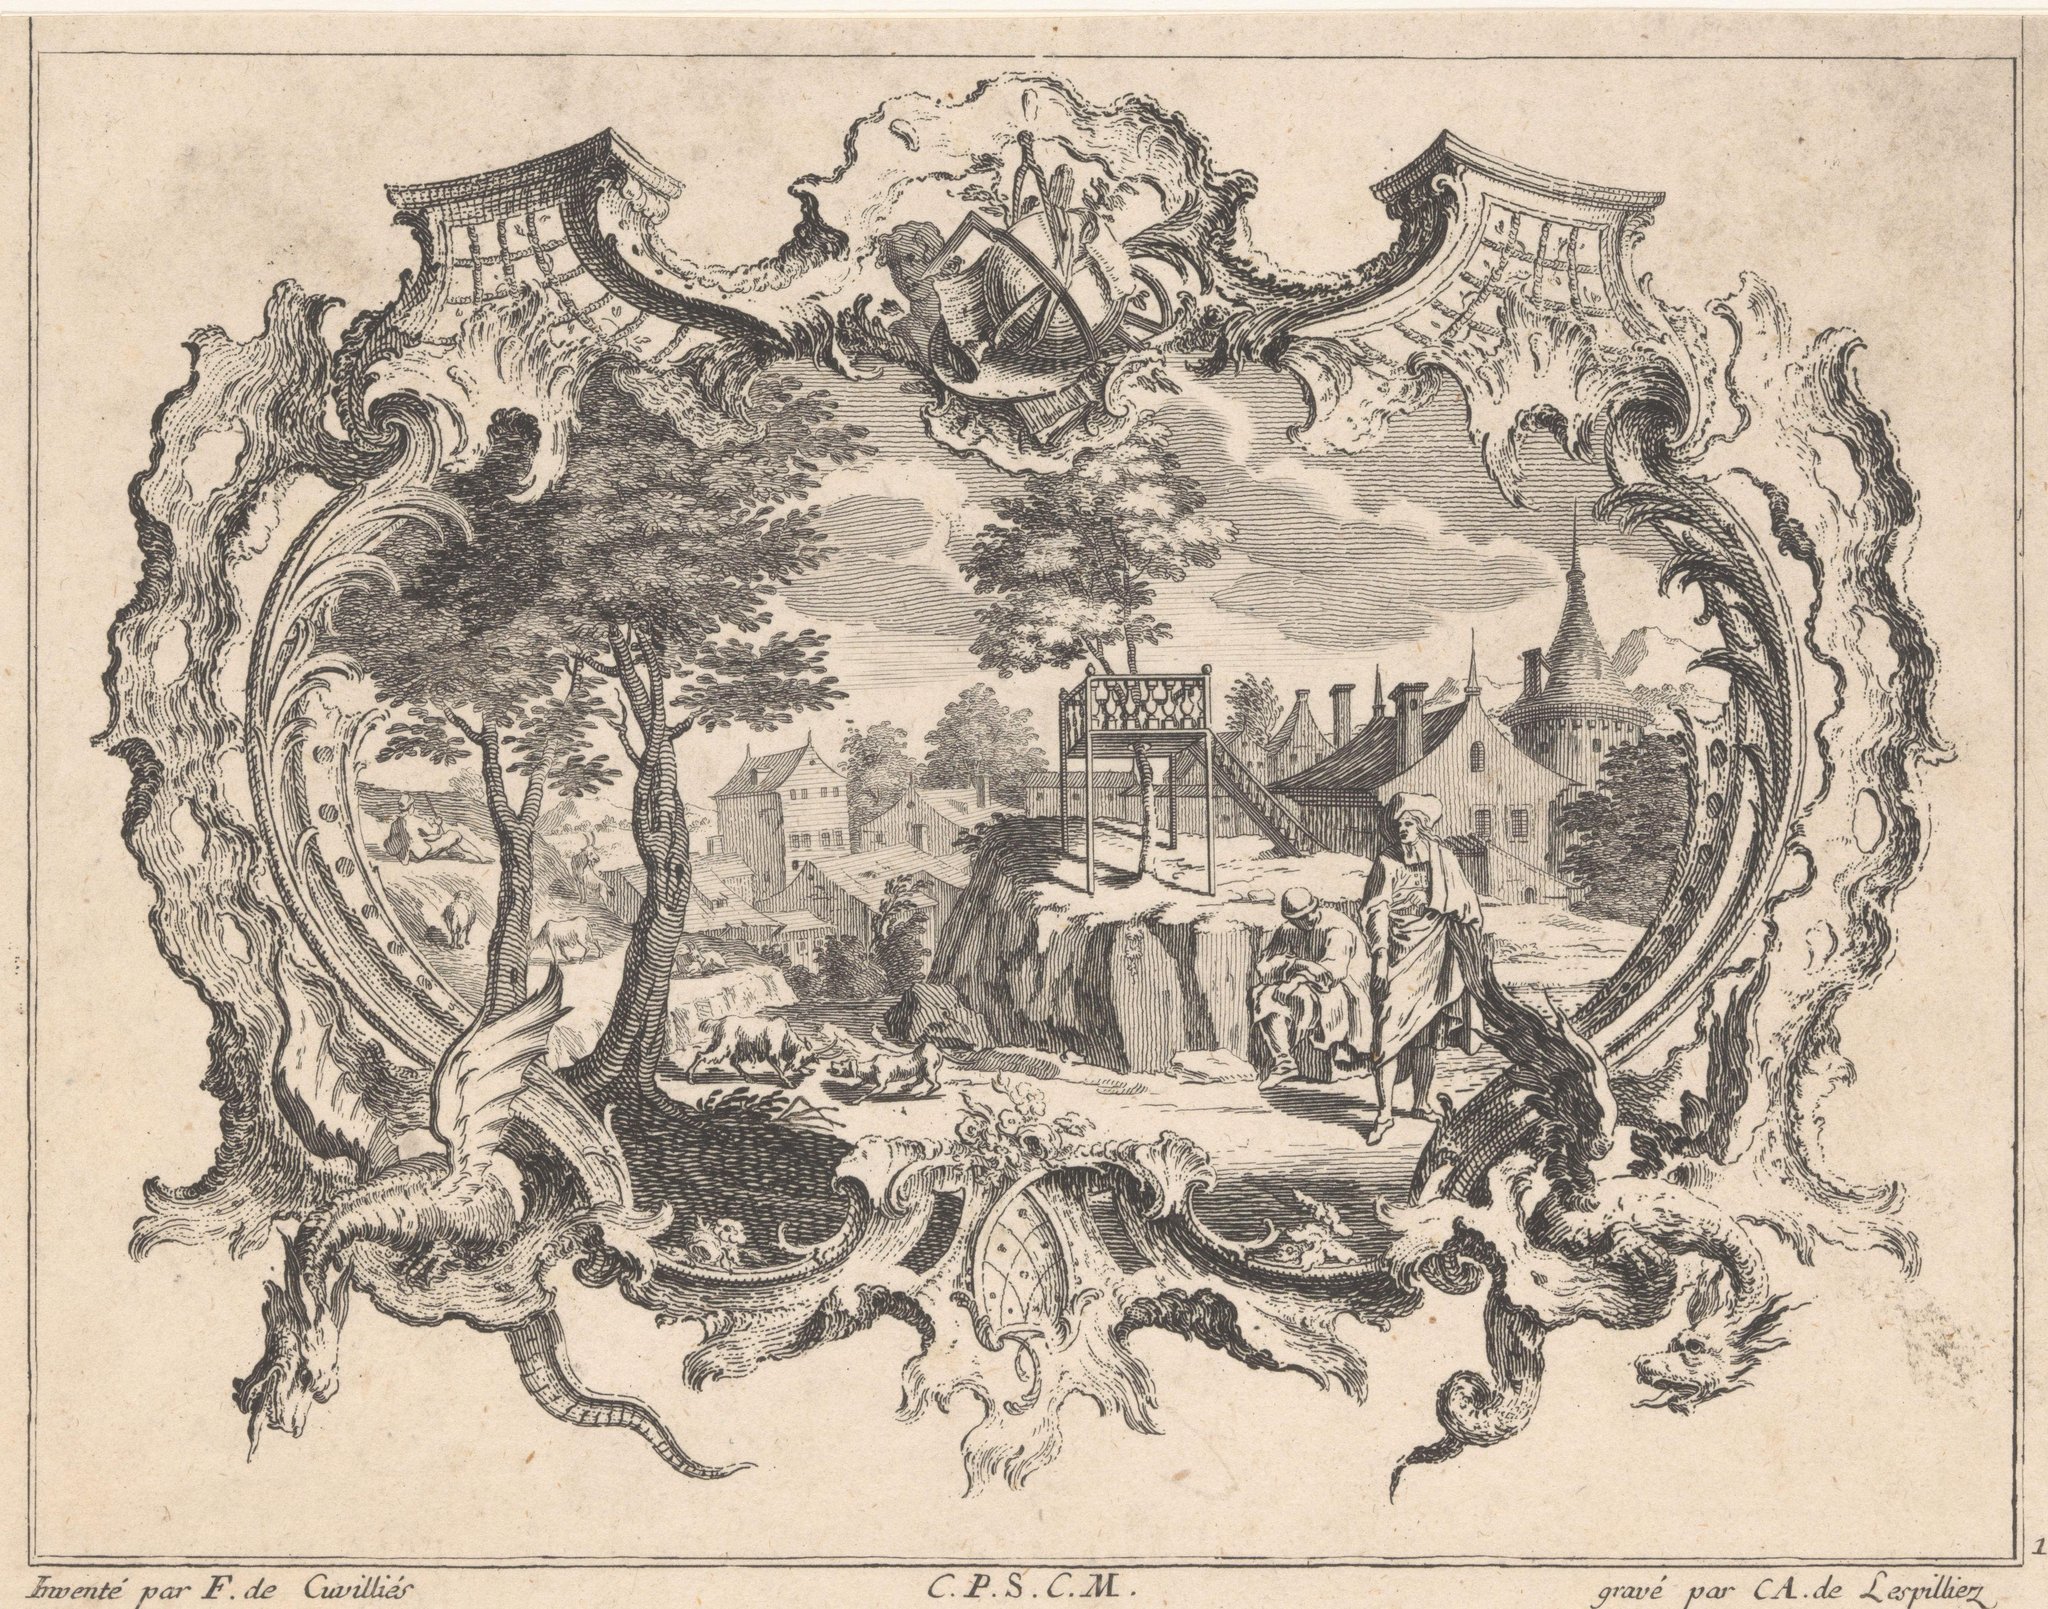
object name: ornament print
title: Man met hond en koeien in berglandschap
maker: carl albert von lespilliez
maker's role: print maker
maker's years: 1723-1796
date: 1745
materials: paper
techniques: etching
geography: germany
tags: cow, agricultural implements, mountains (+ landscape with figures, staffage), dog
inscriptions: collector's mark: Lugt 2228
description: In een berglandschap staat rechts een man met een hond en liggen twee koeien. Links in de achtergrond twee ruiters te paard en architectuur. Rondom de voorstelling een omlijsting met schelpmotieven en agrarische objecten.